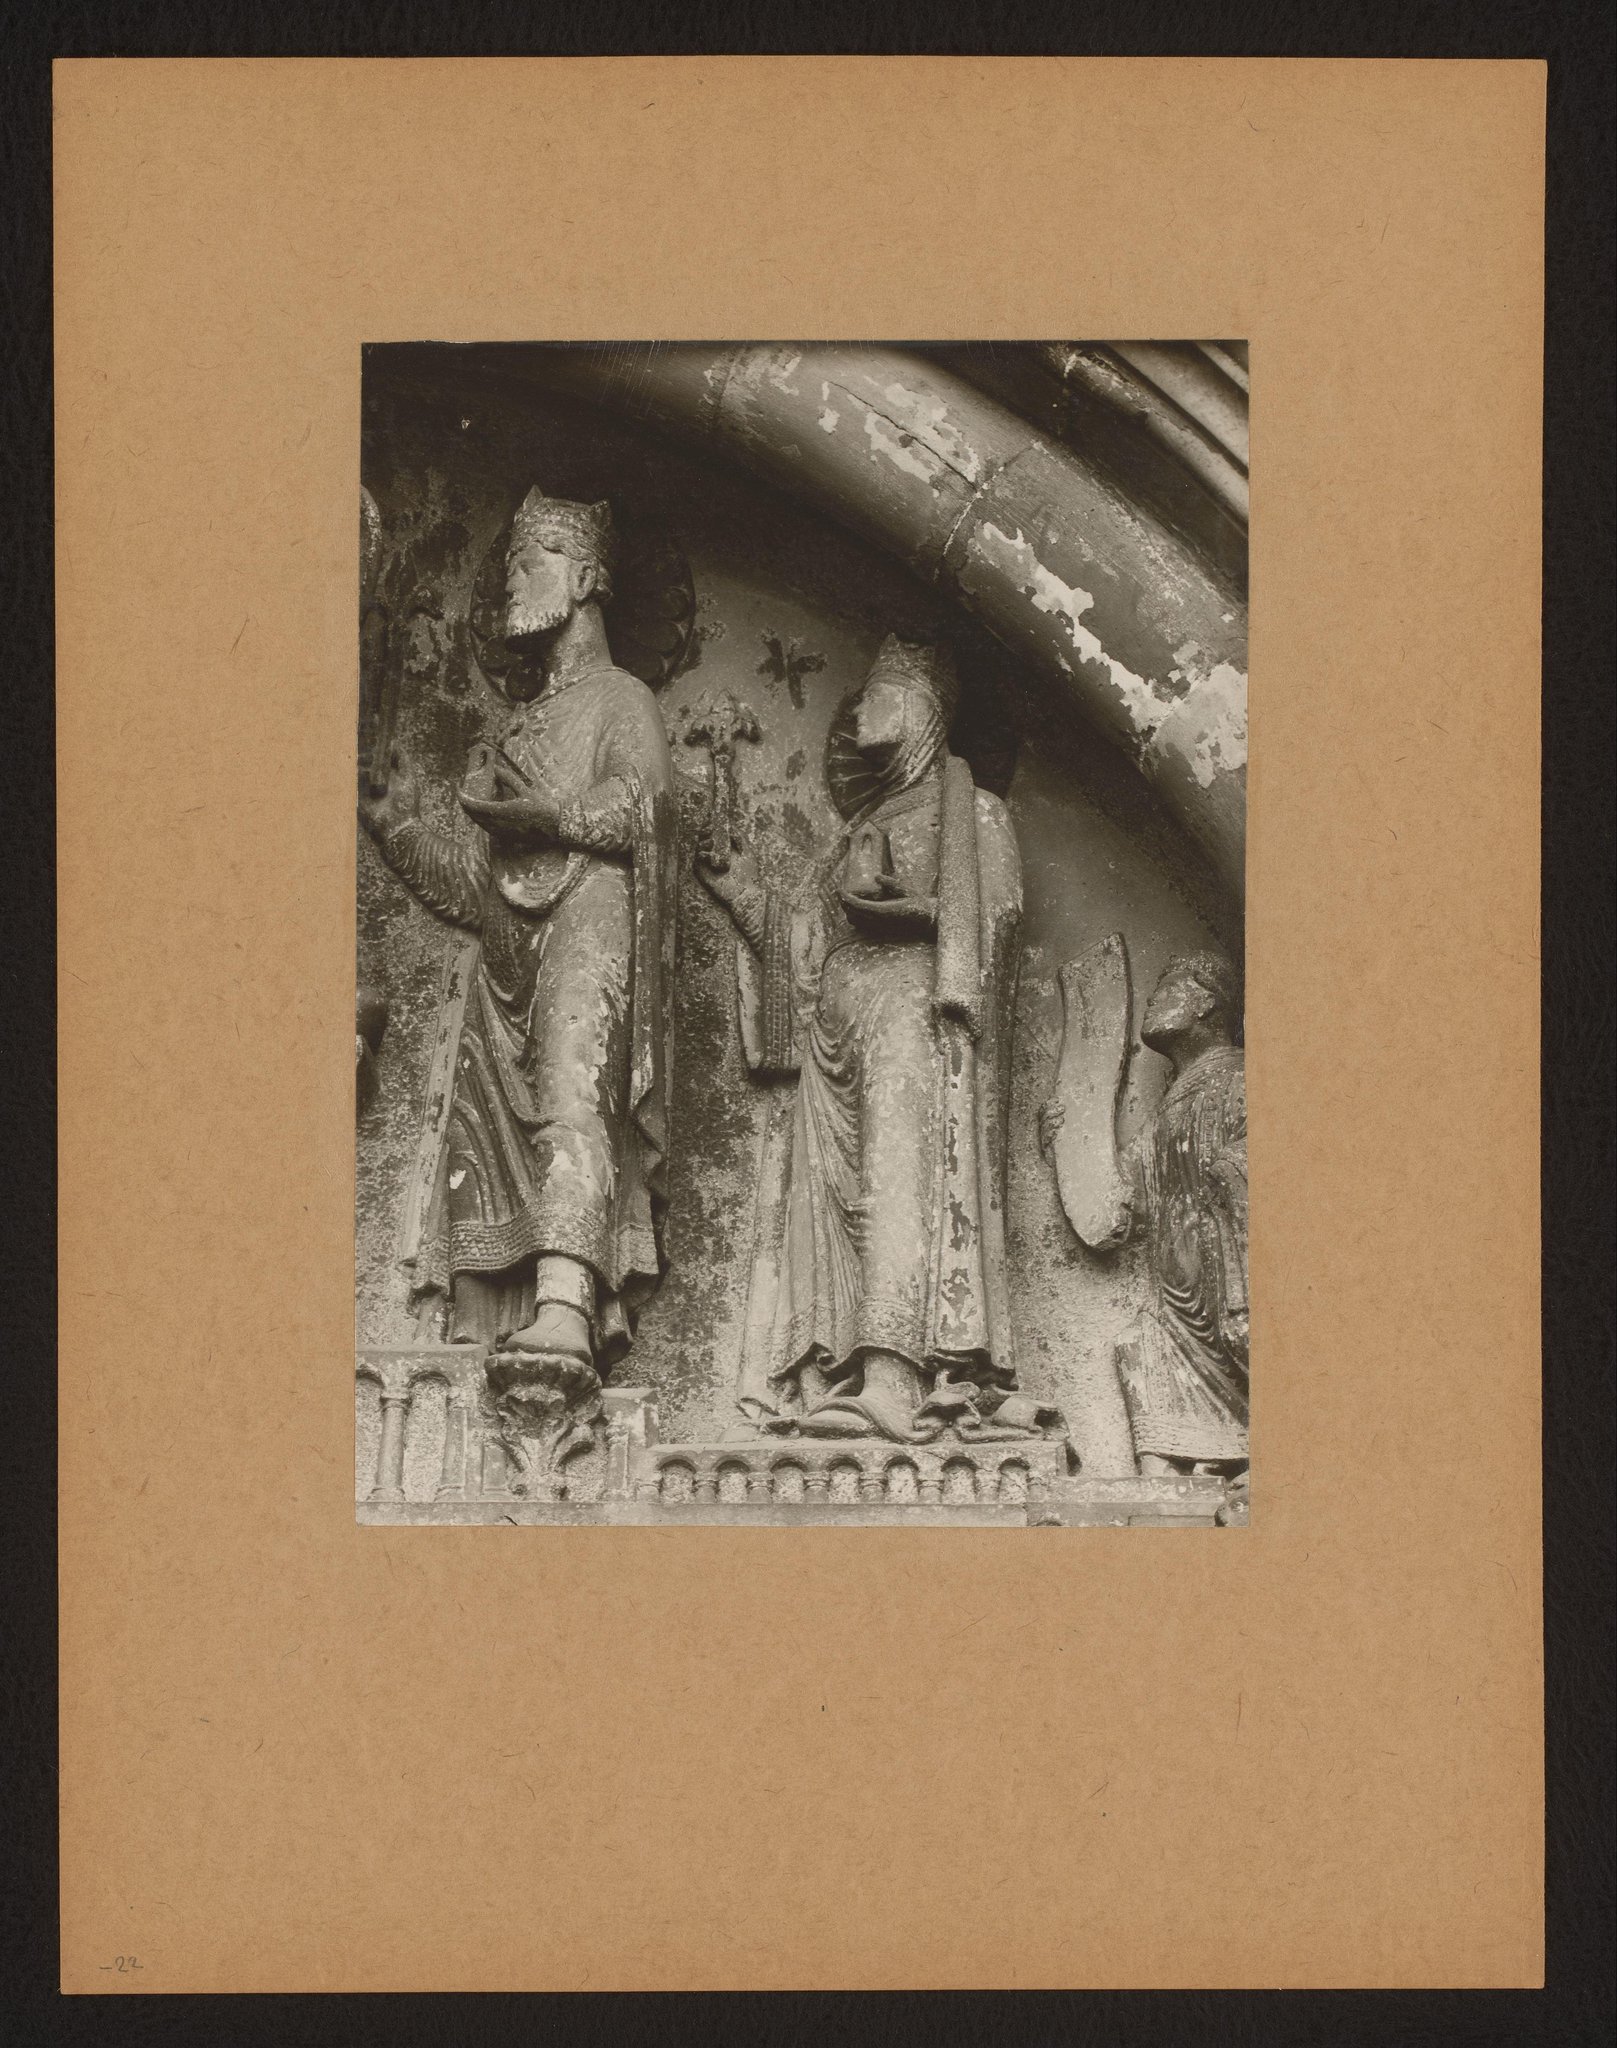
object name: photograph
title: Detail van het timpaan van de Gnadenpforte in de dom van Bamberg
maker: Anonymous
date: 1900-1920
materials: paper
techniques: gelatin silver print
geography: bamberg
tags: church (exterior)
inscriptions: number: ‘22.’